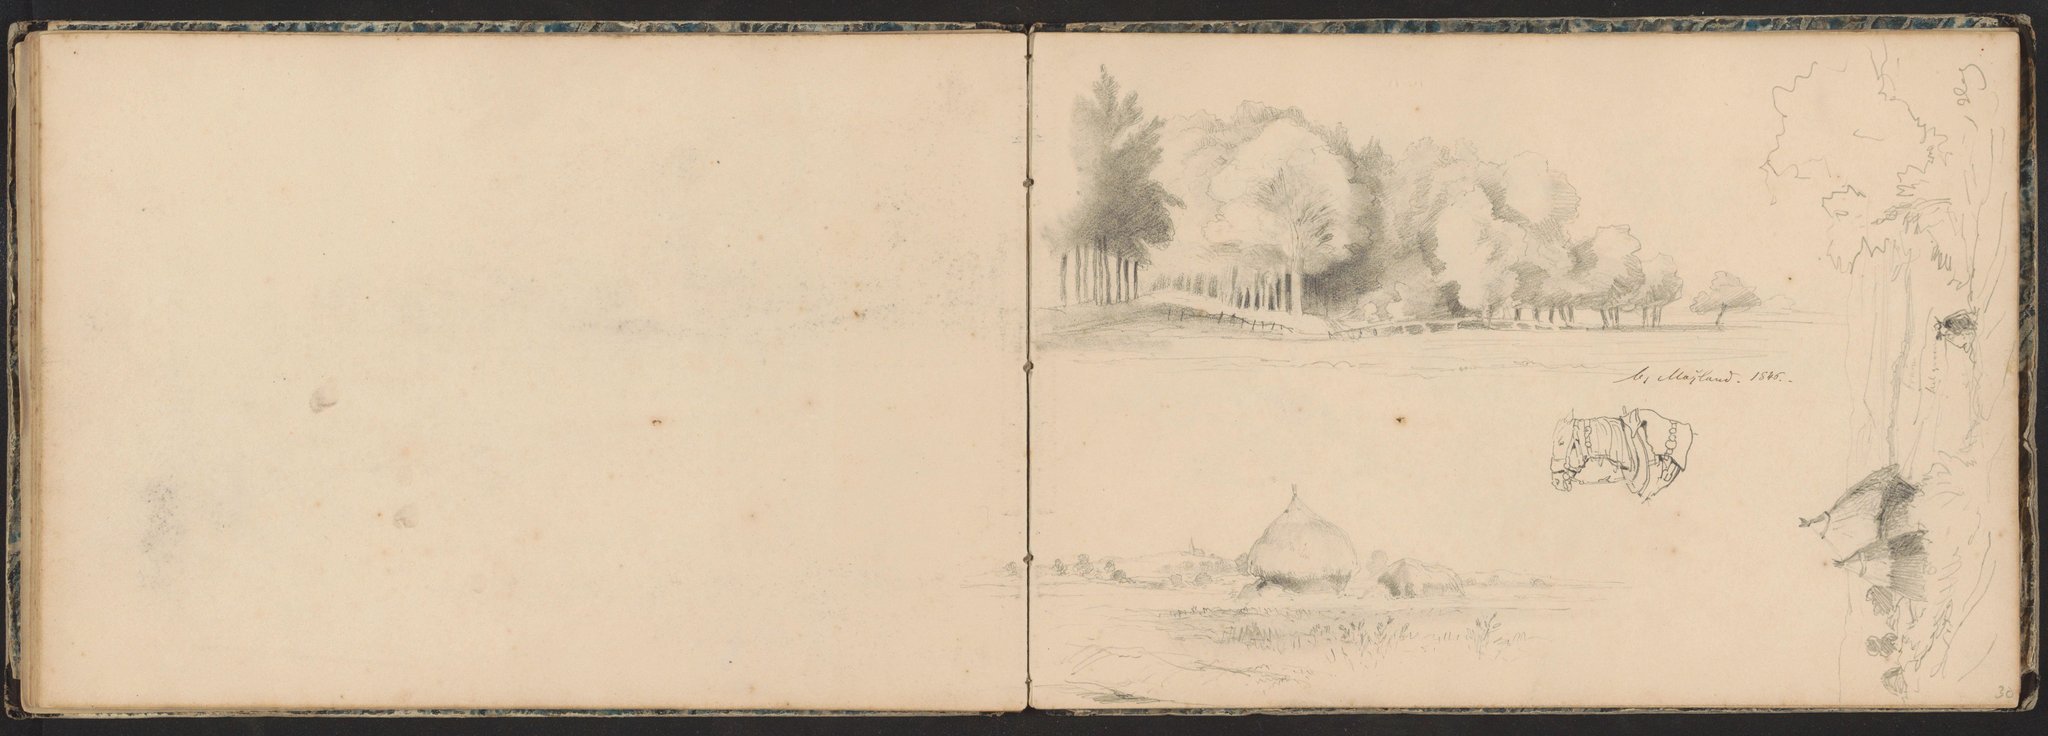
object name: sketchbook leaf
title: Landschappen met hooibalen en een boslandschap bij Moyland in Kleef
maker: johannes tavenraat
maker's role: draughtsman, painter, print maker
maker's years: 1809-1881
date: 1846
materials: paper, pencil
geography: cleves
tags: forest, wood, horse, hay-stack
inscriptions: date and inscription: ‘bij Moyland/ 1846’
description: Tevens een studie van een paardenhoofd. Blad 30 recto uit een schetsboek met 44 bladen.